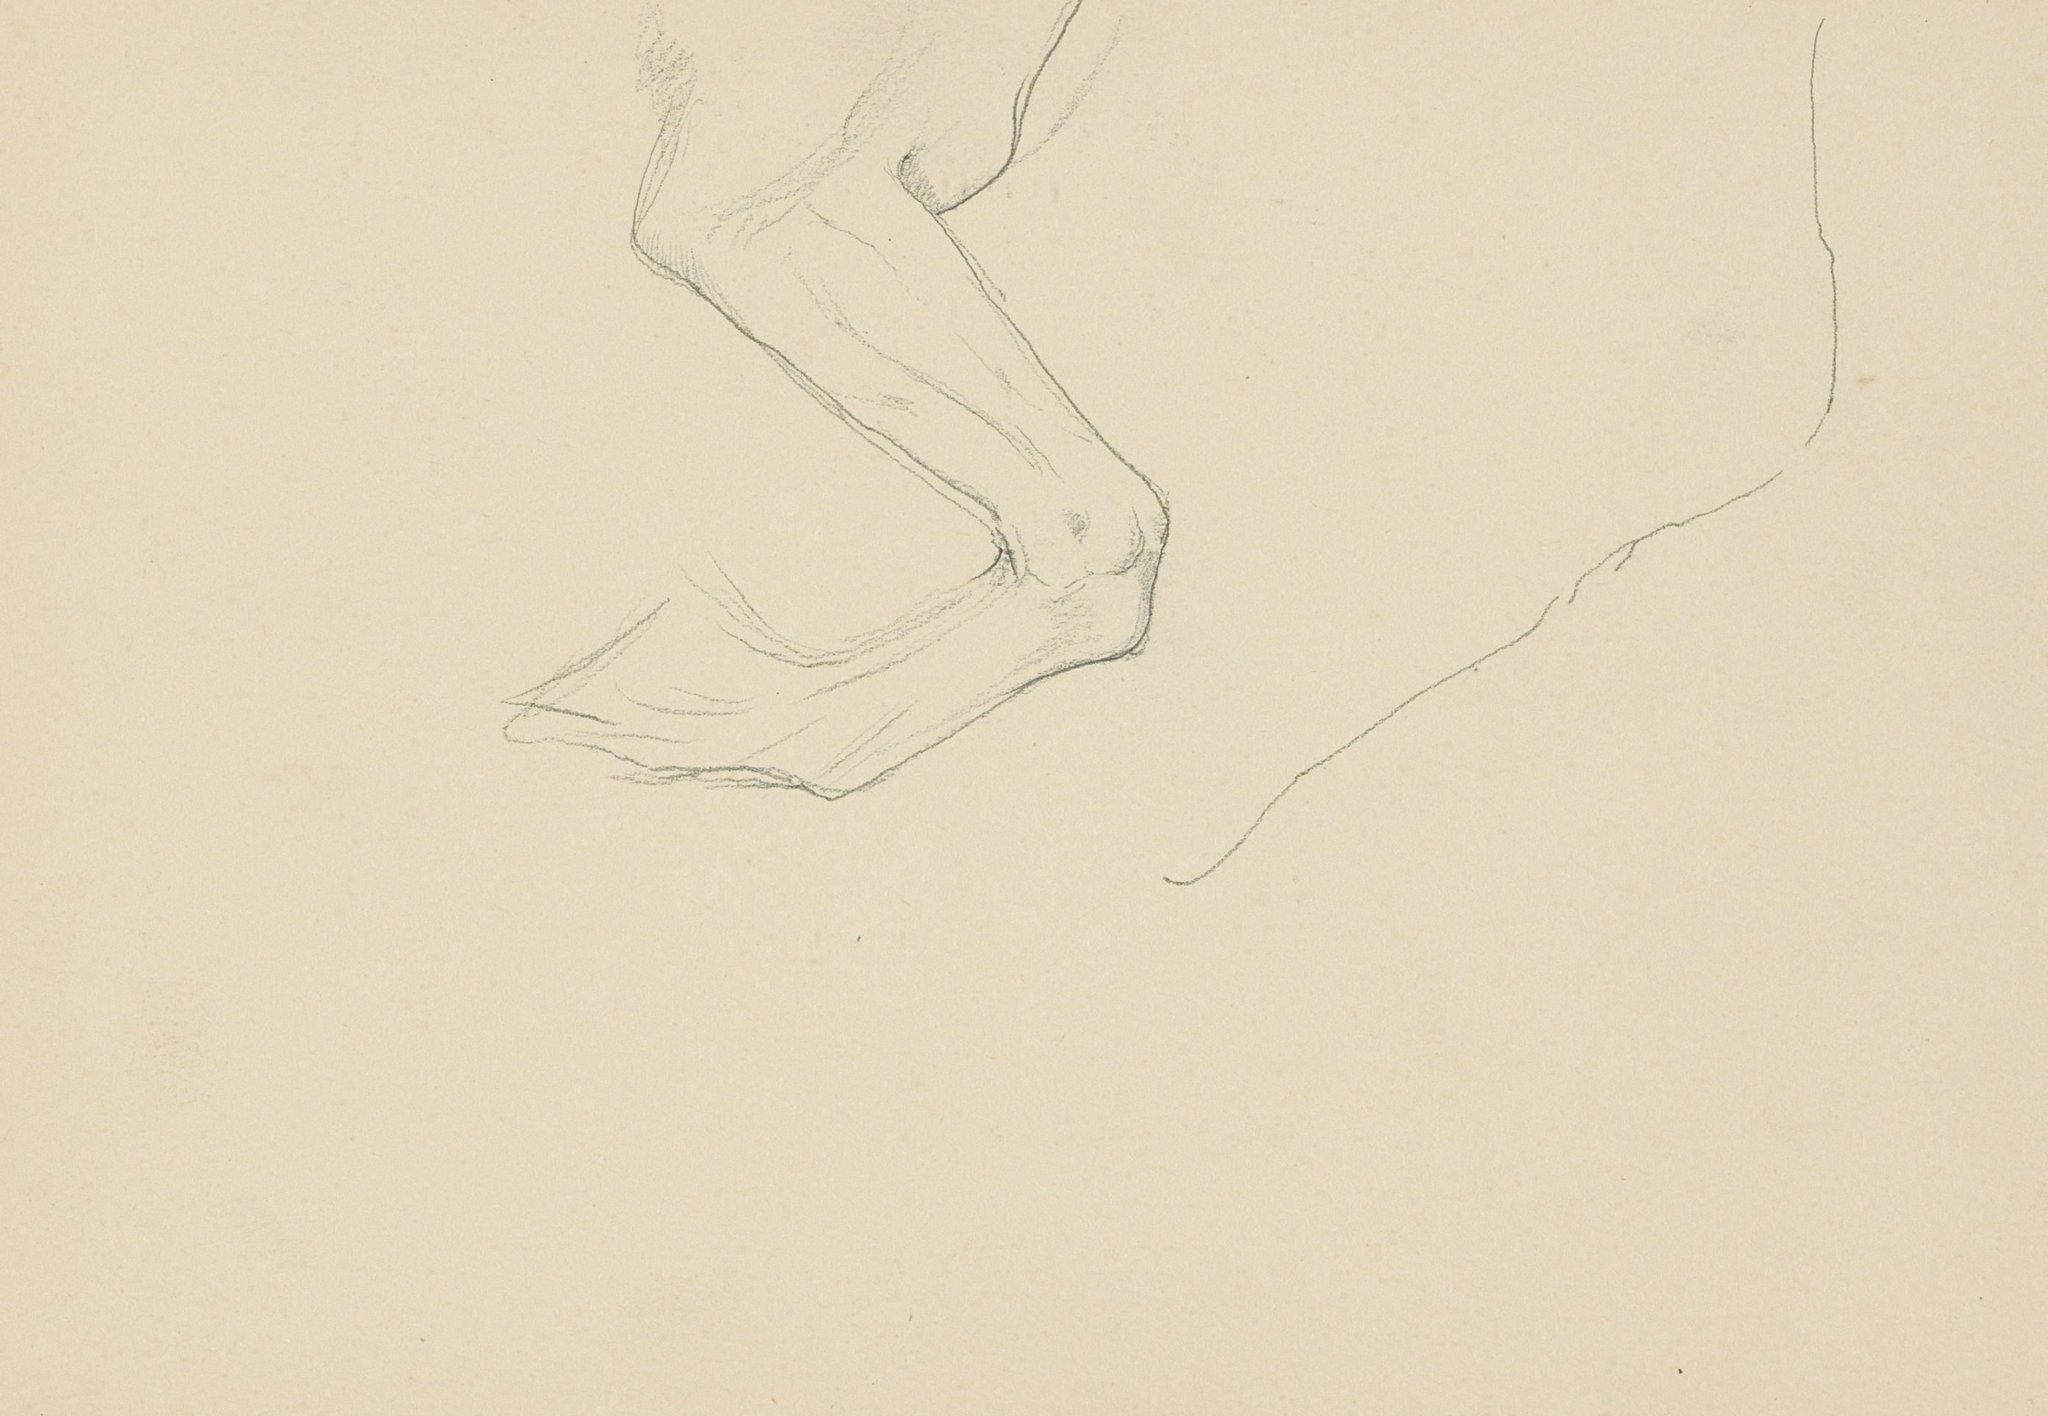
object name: sketchbook leaf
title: Gebogen been van een paard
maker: antoon derkinderen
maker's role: draughtsman, painter, print maker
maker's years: 1859-1925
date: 1869-1925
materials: paper, pencil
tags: horse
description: Blad 2 recto uit een schetsboek met 28 bladen.